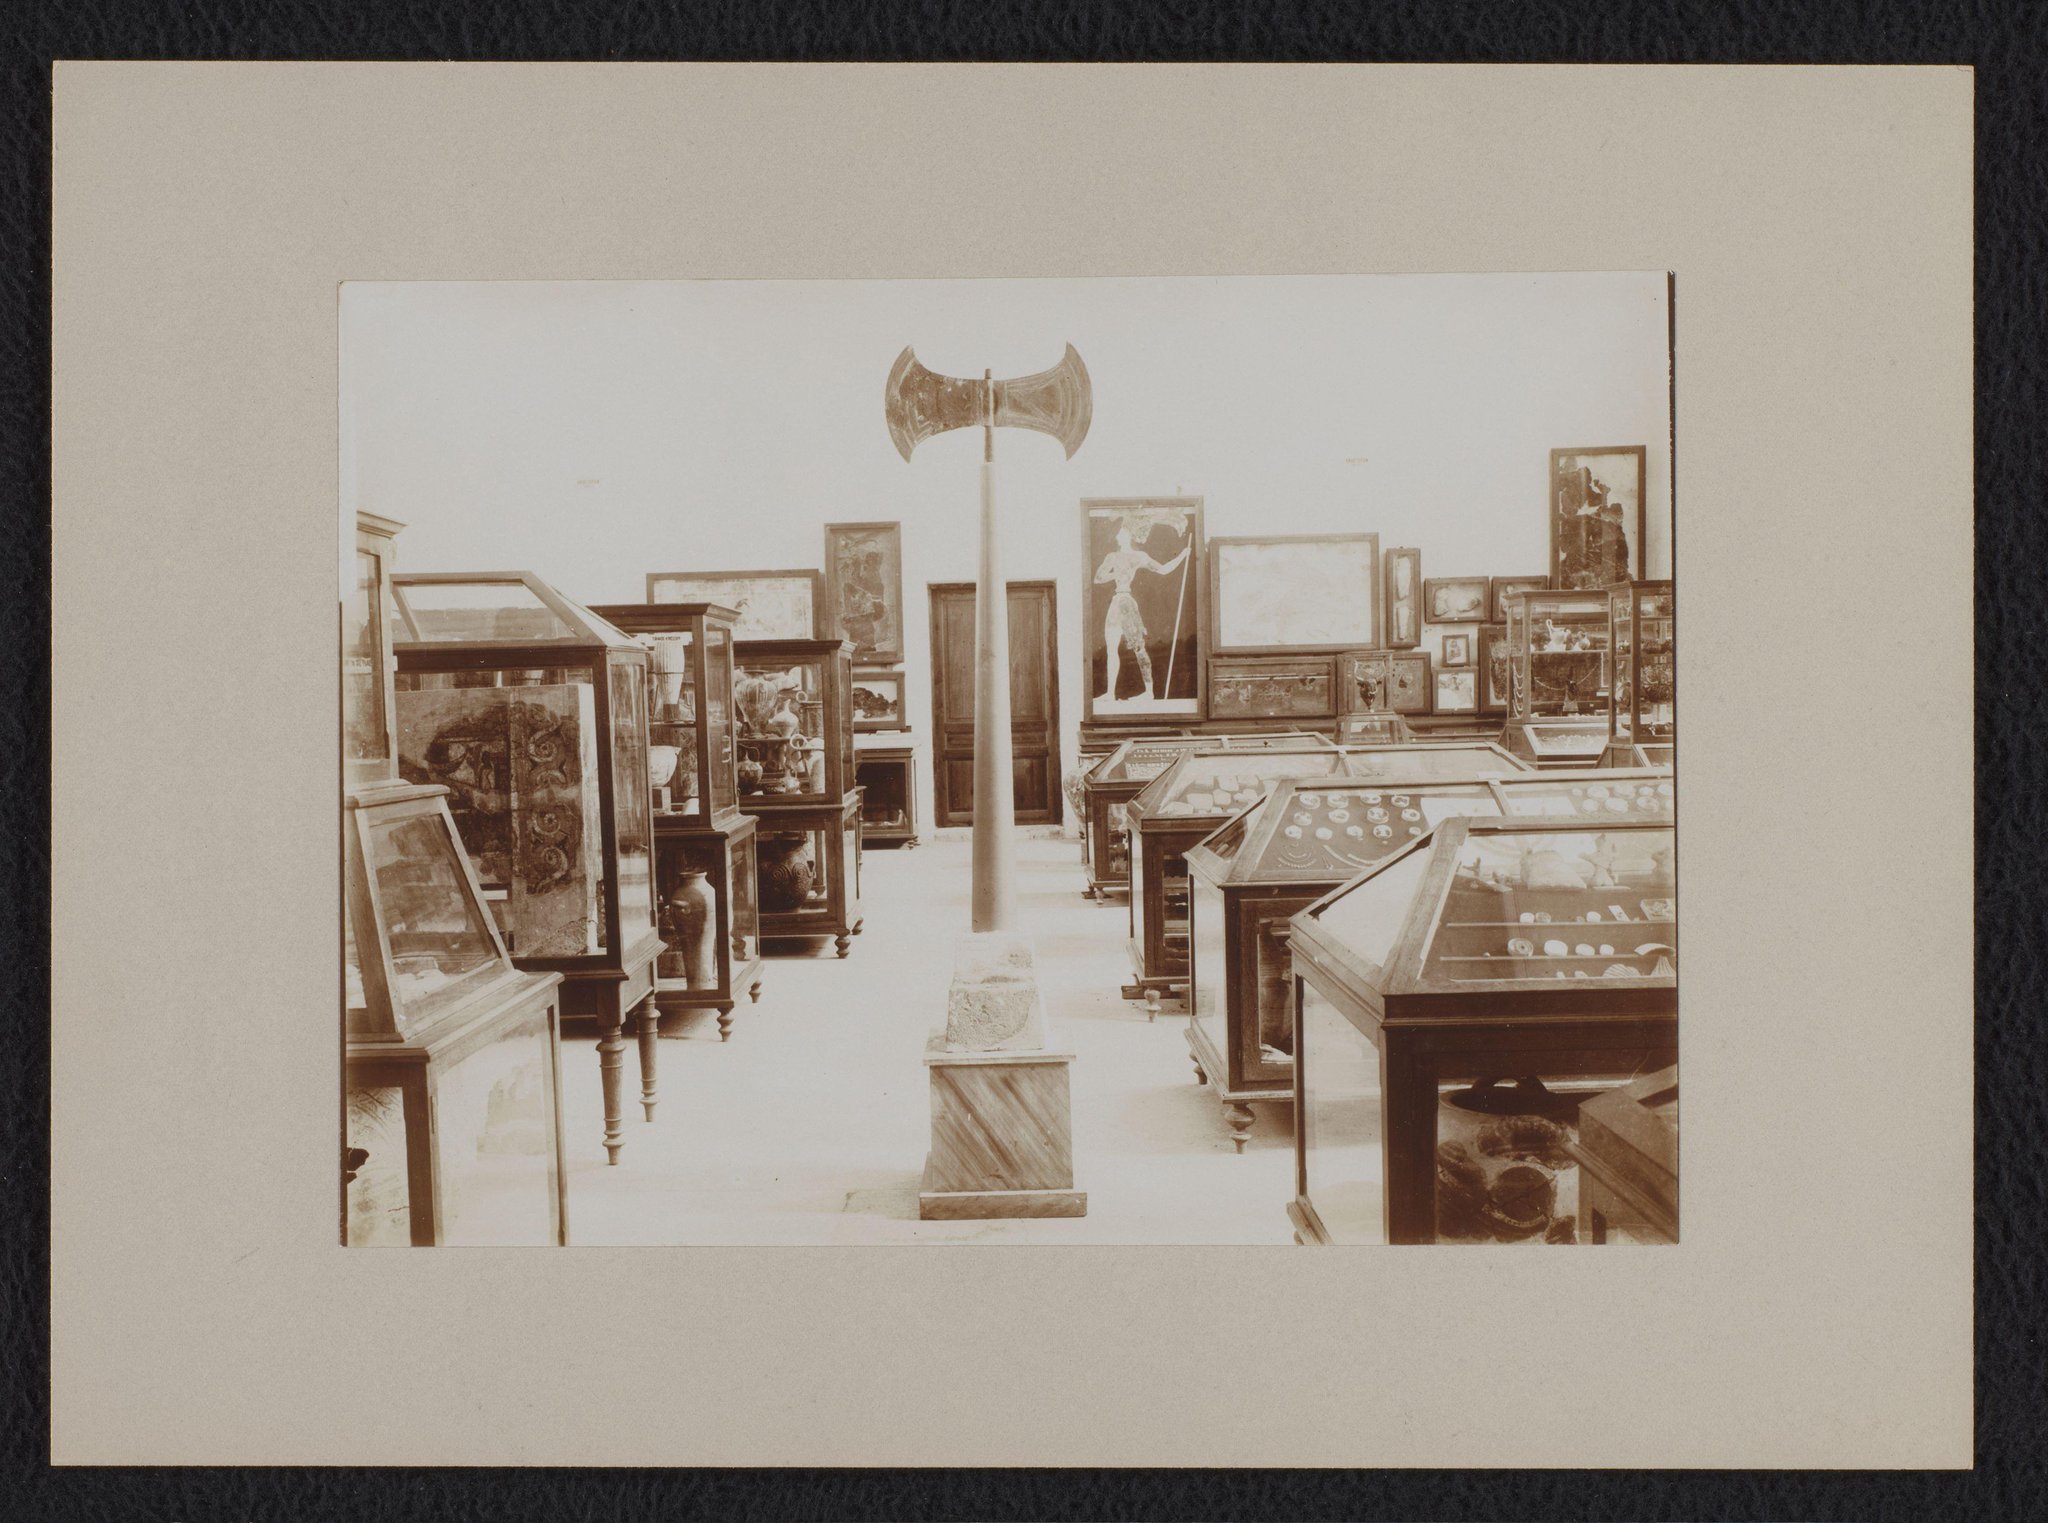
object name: photograph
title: Dubbele bijl in museum op Kreta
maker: Anonymous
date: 1895-1915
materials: cardboard, paper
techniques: gelatin silver print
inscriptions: annotation: ‘57. Kreta. Muzeum te Candia Dubbele bijl symbool der goddelijkheid’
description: Dubbele bijl, symbool der goddelijkheid, te midden van kasten met voorwerpen.